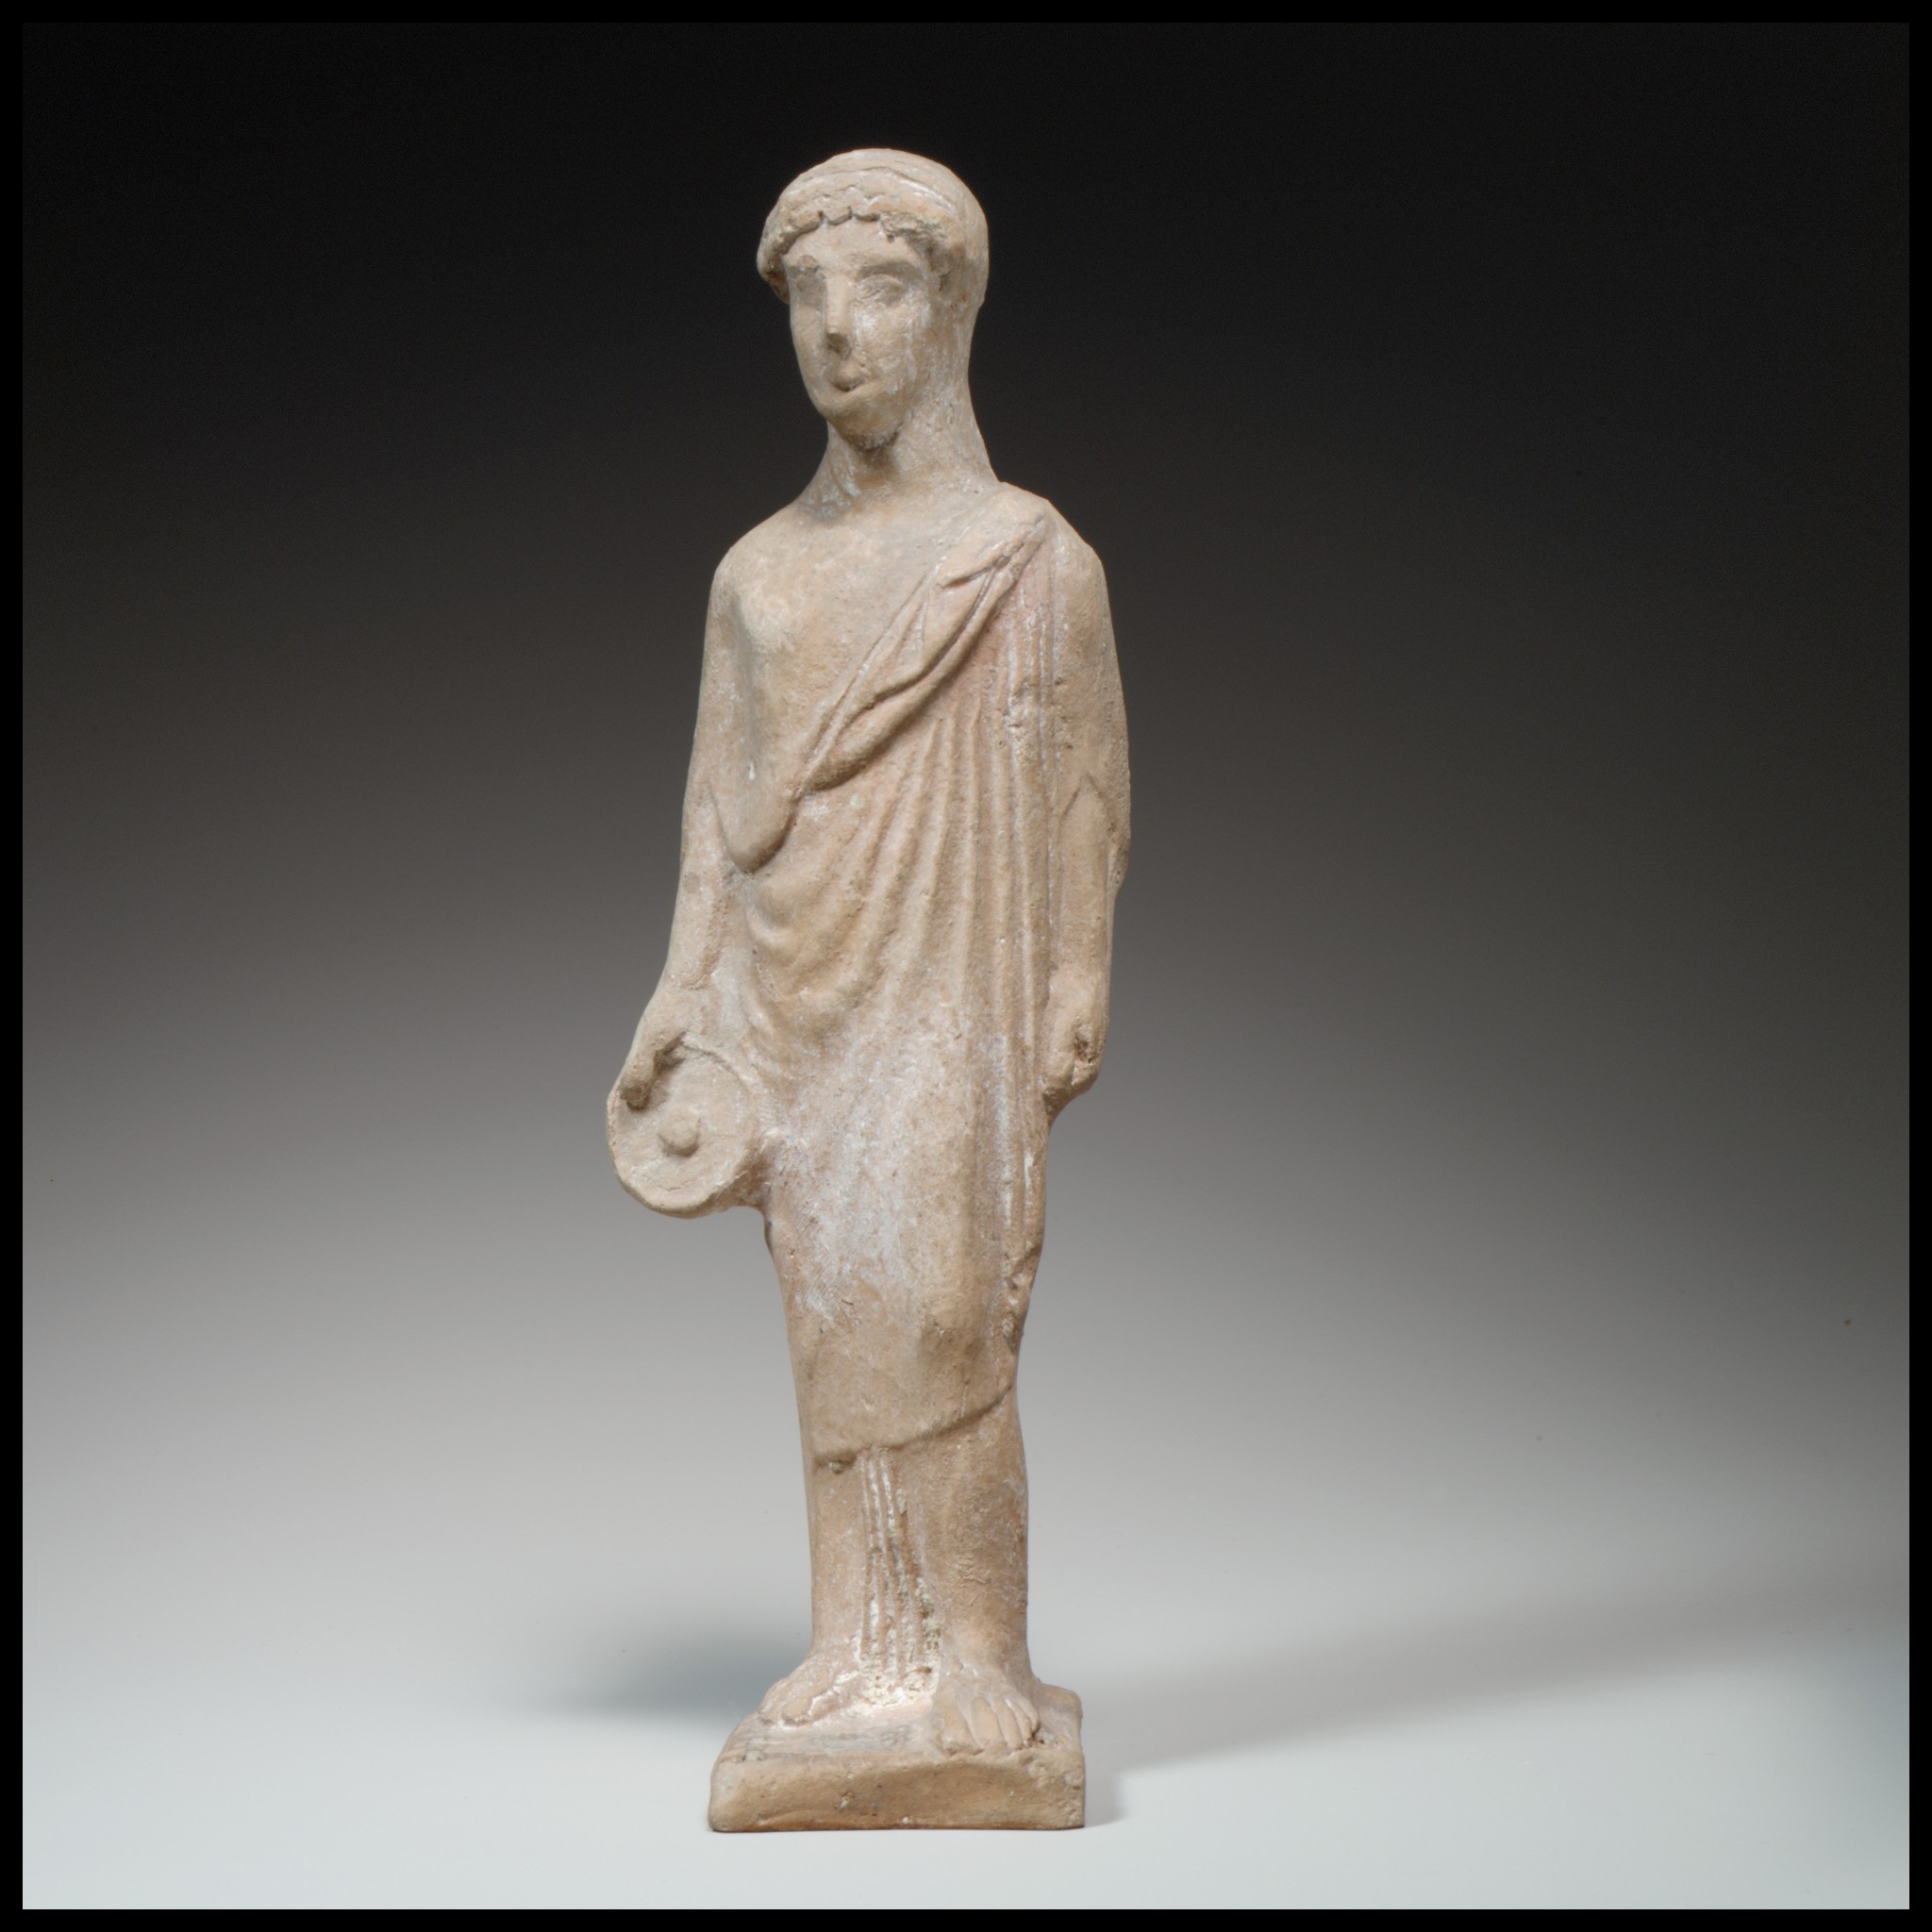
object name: statuette of a woman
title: Standing female figurine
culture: greek, attic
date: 500-468 BCE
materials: terracotta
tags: women